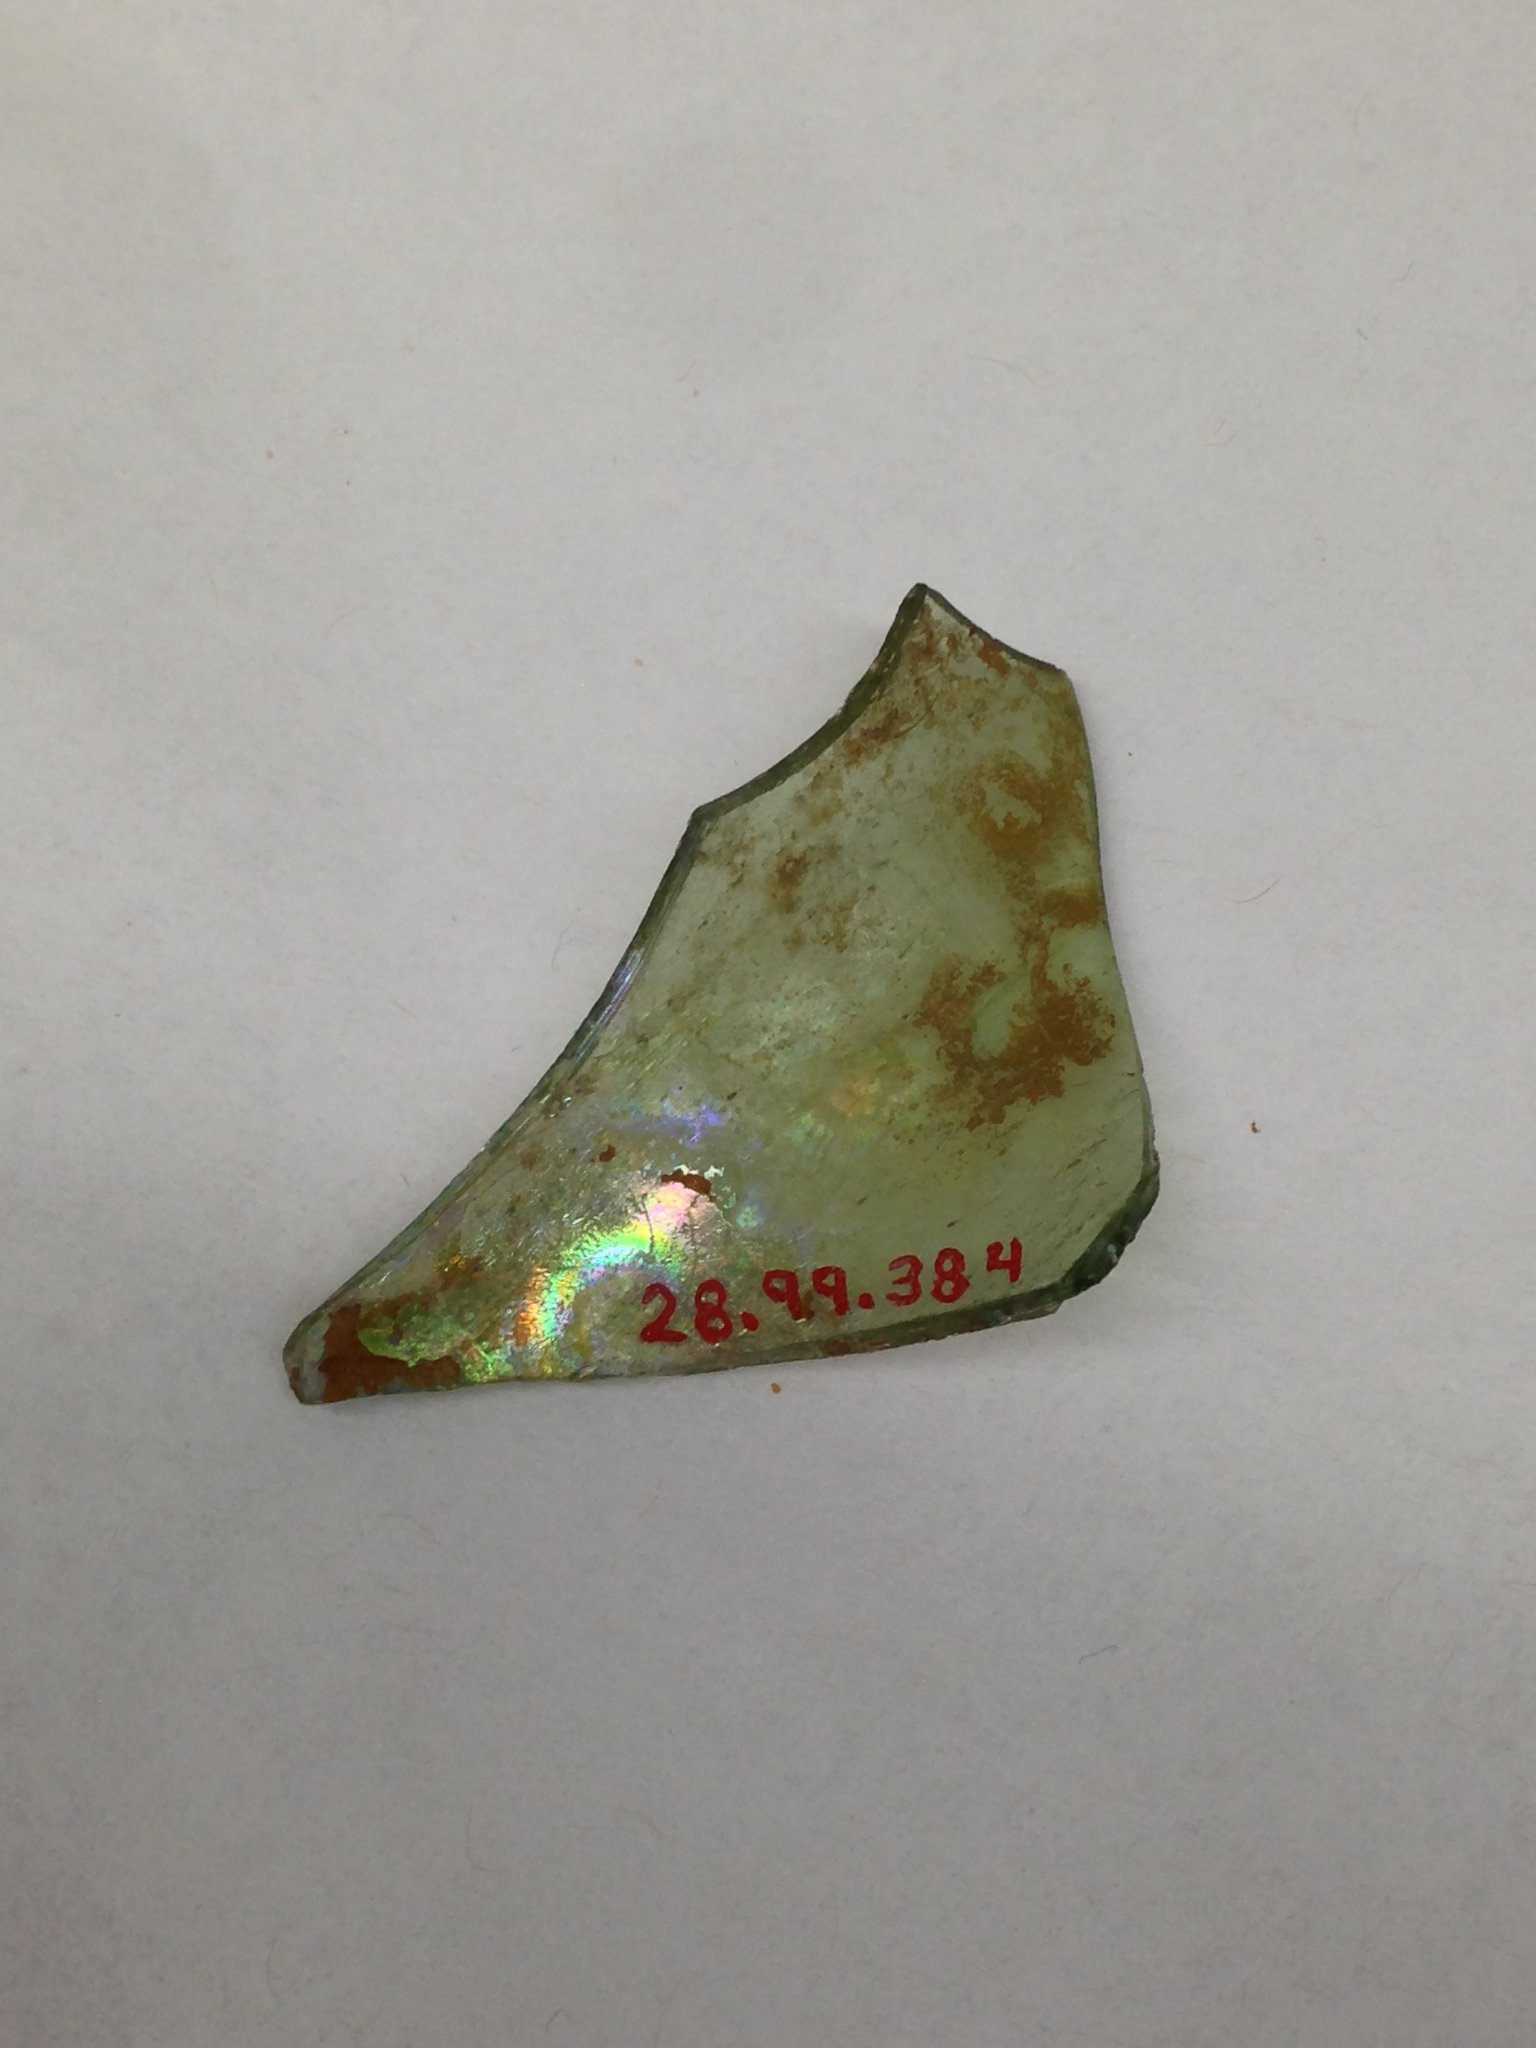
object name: fragment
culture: european or middle eastern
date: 1150-1250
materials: ceramic, glass